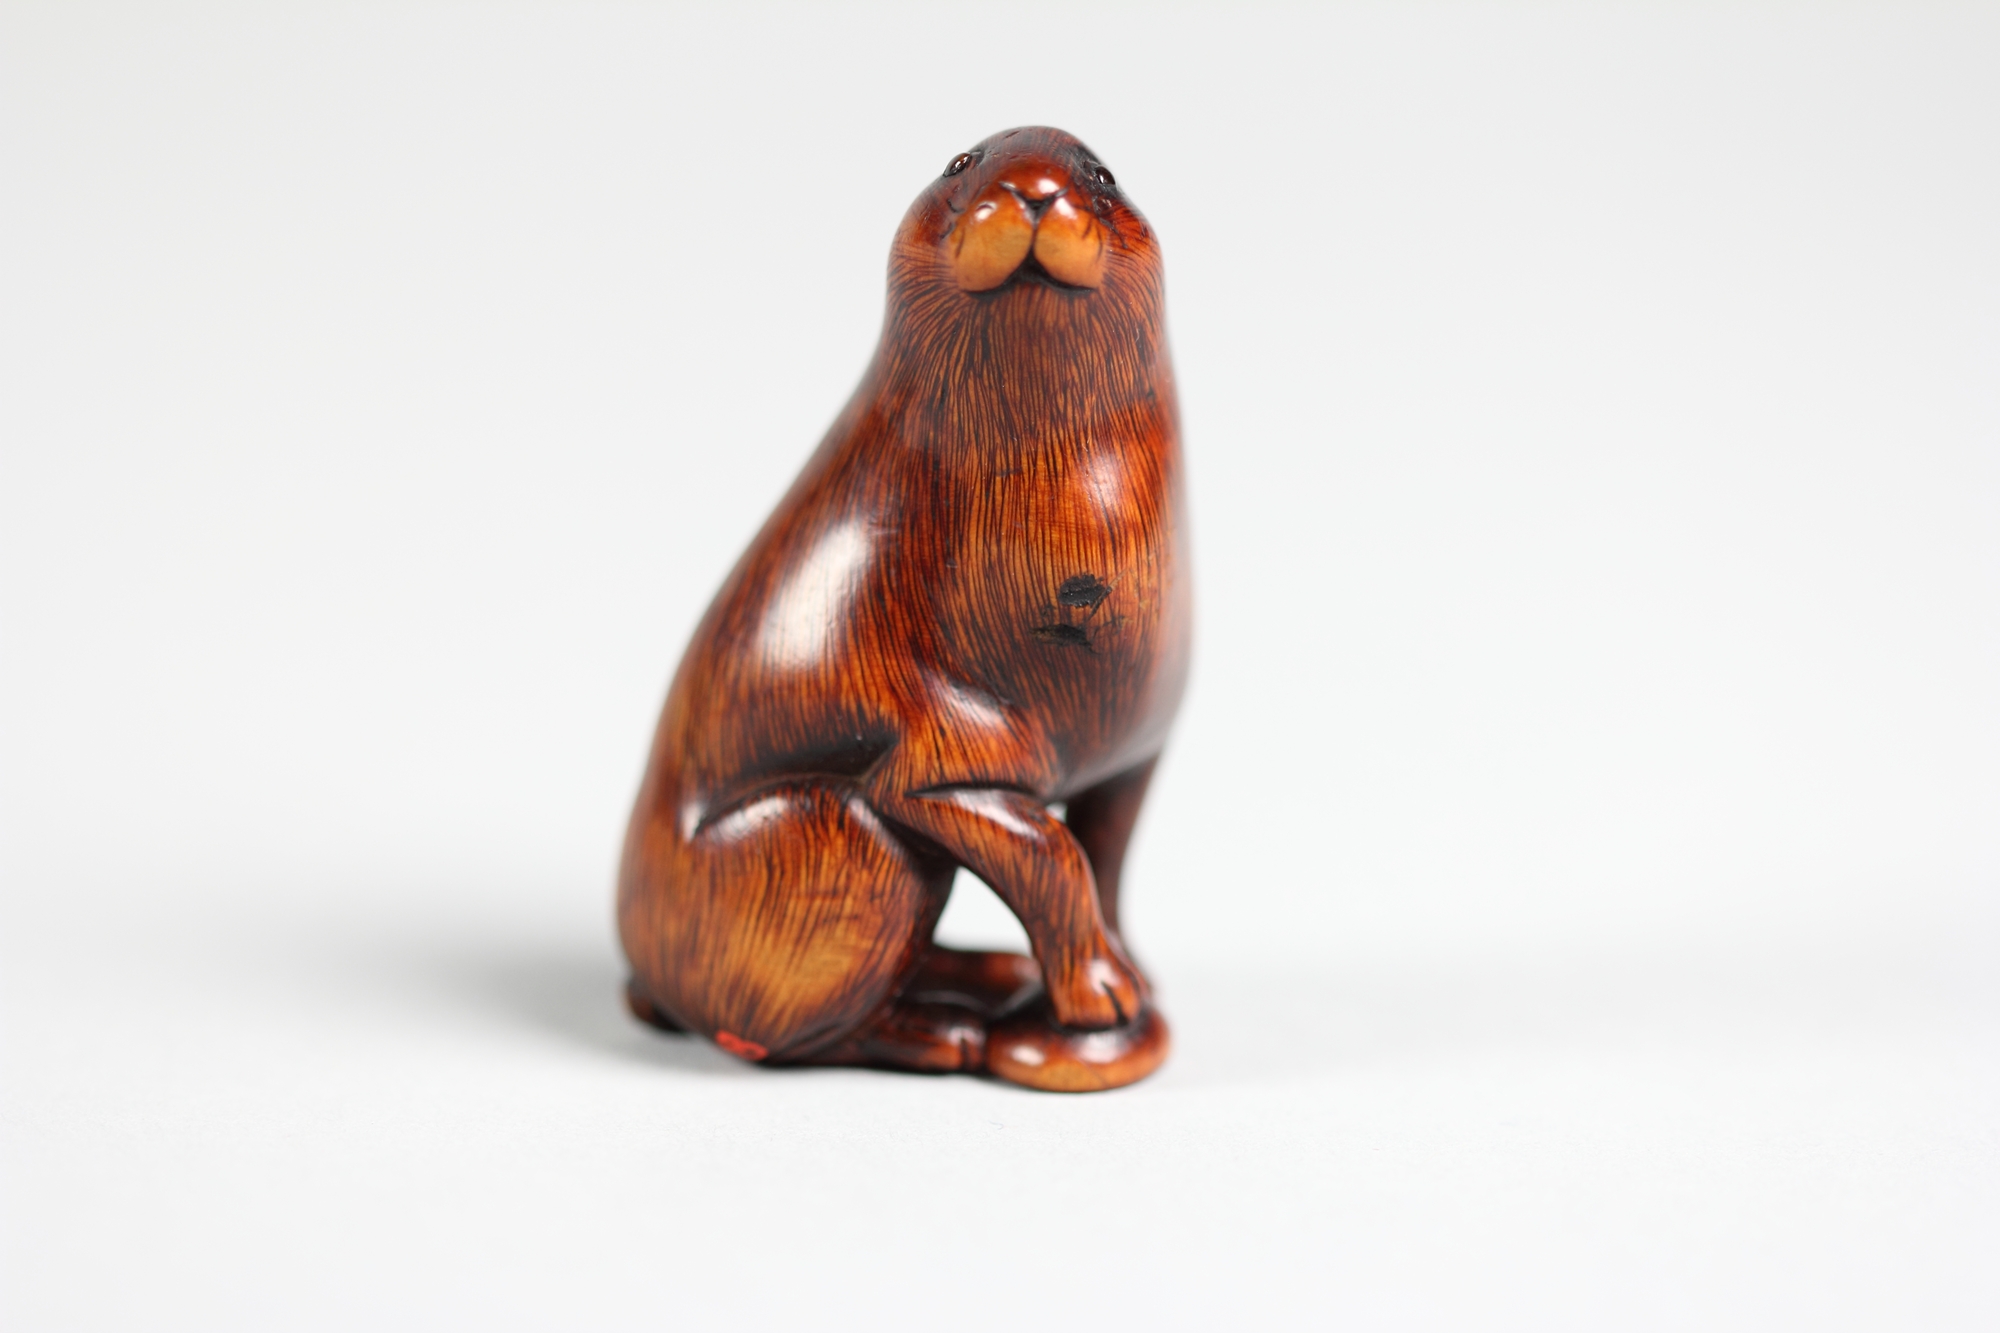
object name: netsuke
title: Netsuke of Rabbit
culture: japanese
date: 1801-1900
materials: wood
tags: rabbits